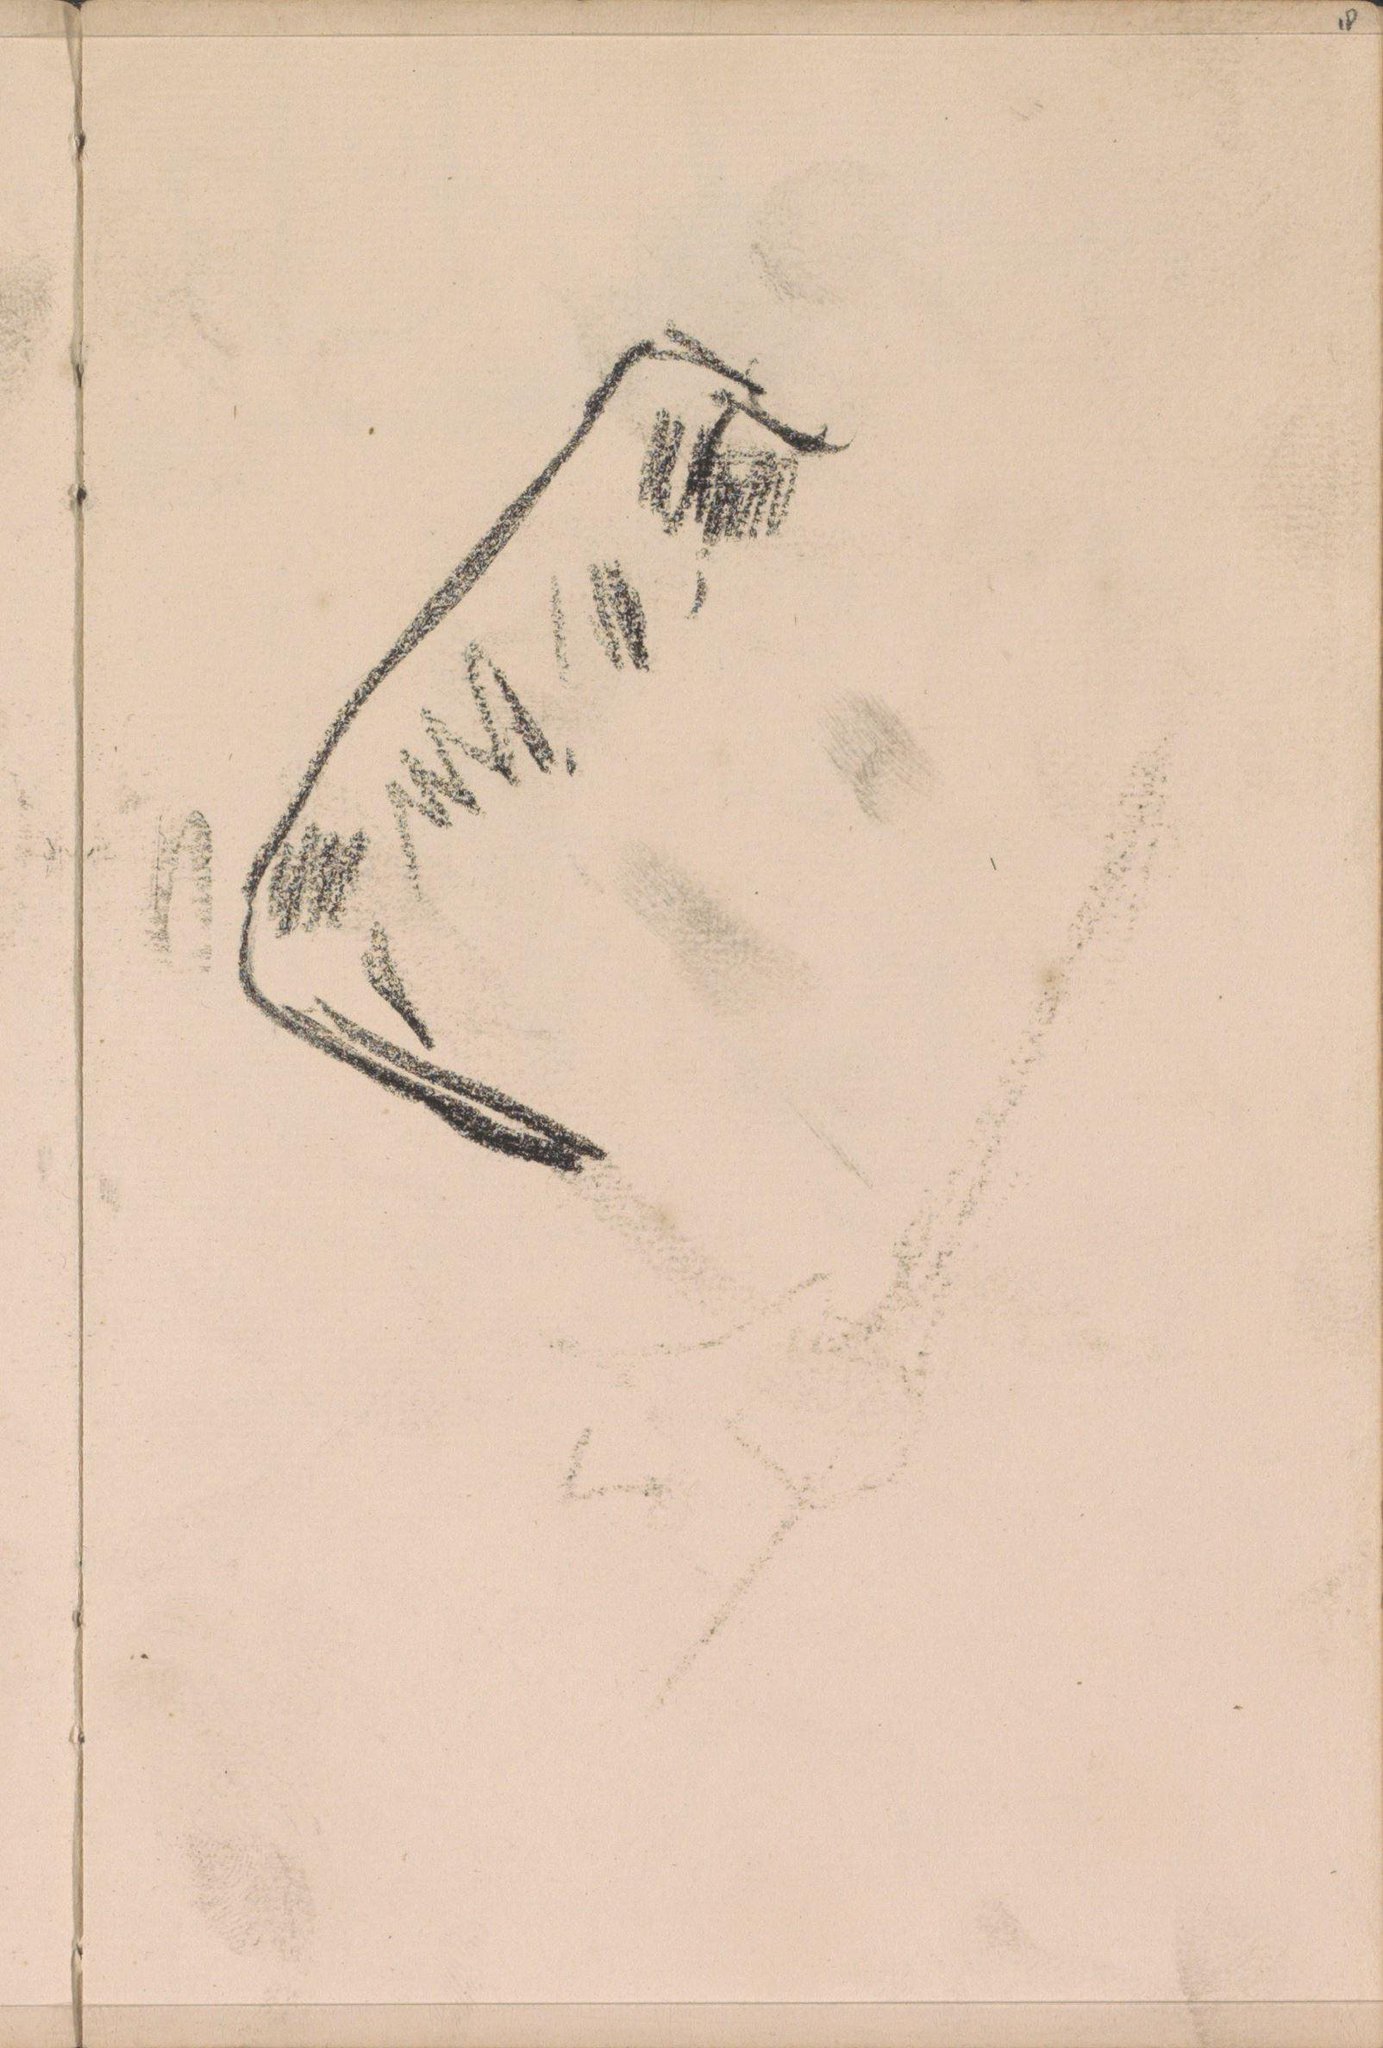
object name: sketchbook leaf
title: Studie, mogelijk van een dier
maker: george hendrik breitner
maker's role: draughtsman, painter, print maker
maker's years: 1857-1923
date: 1883-1885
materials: chalk, paper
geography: the hague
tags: mammals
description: Pagina 18 uit een schetsboek met 18 bladen.